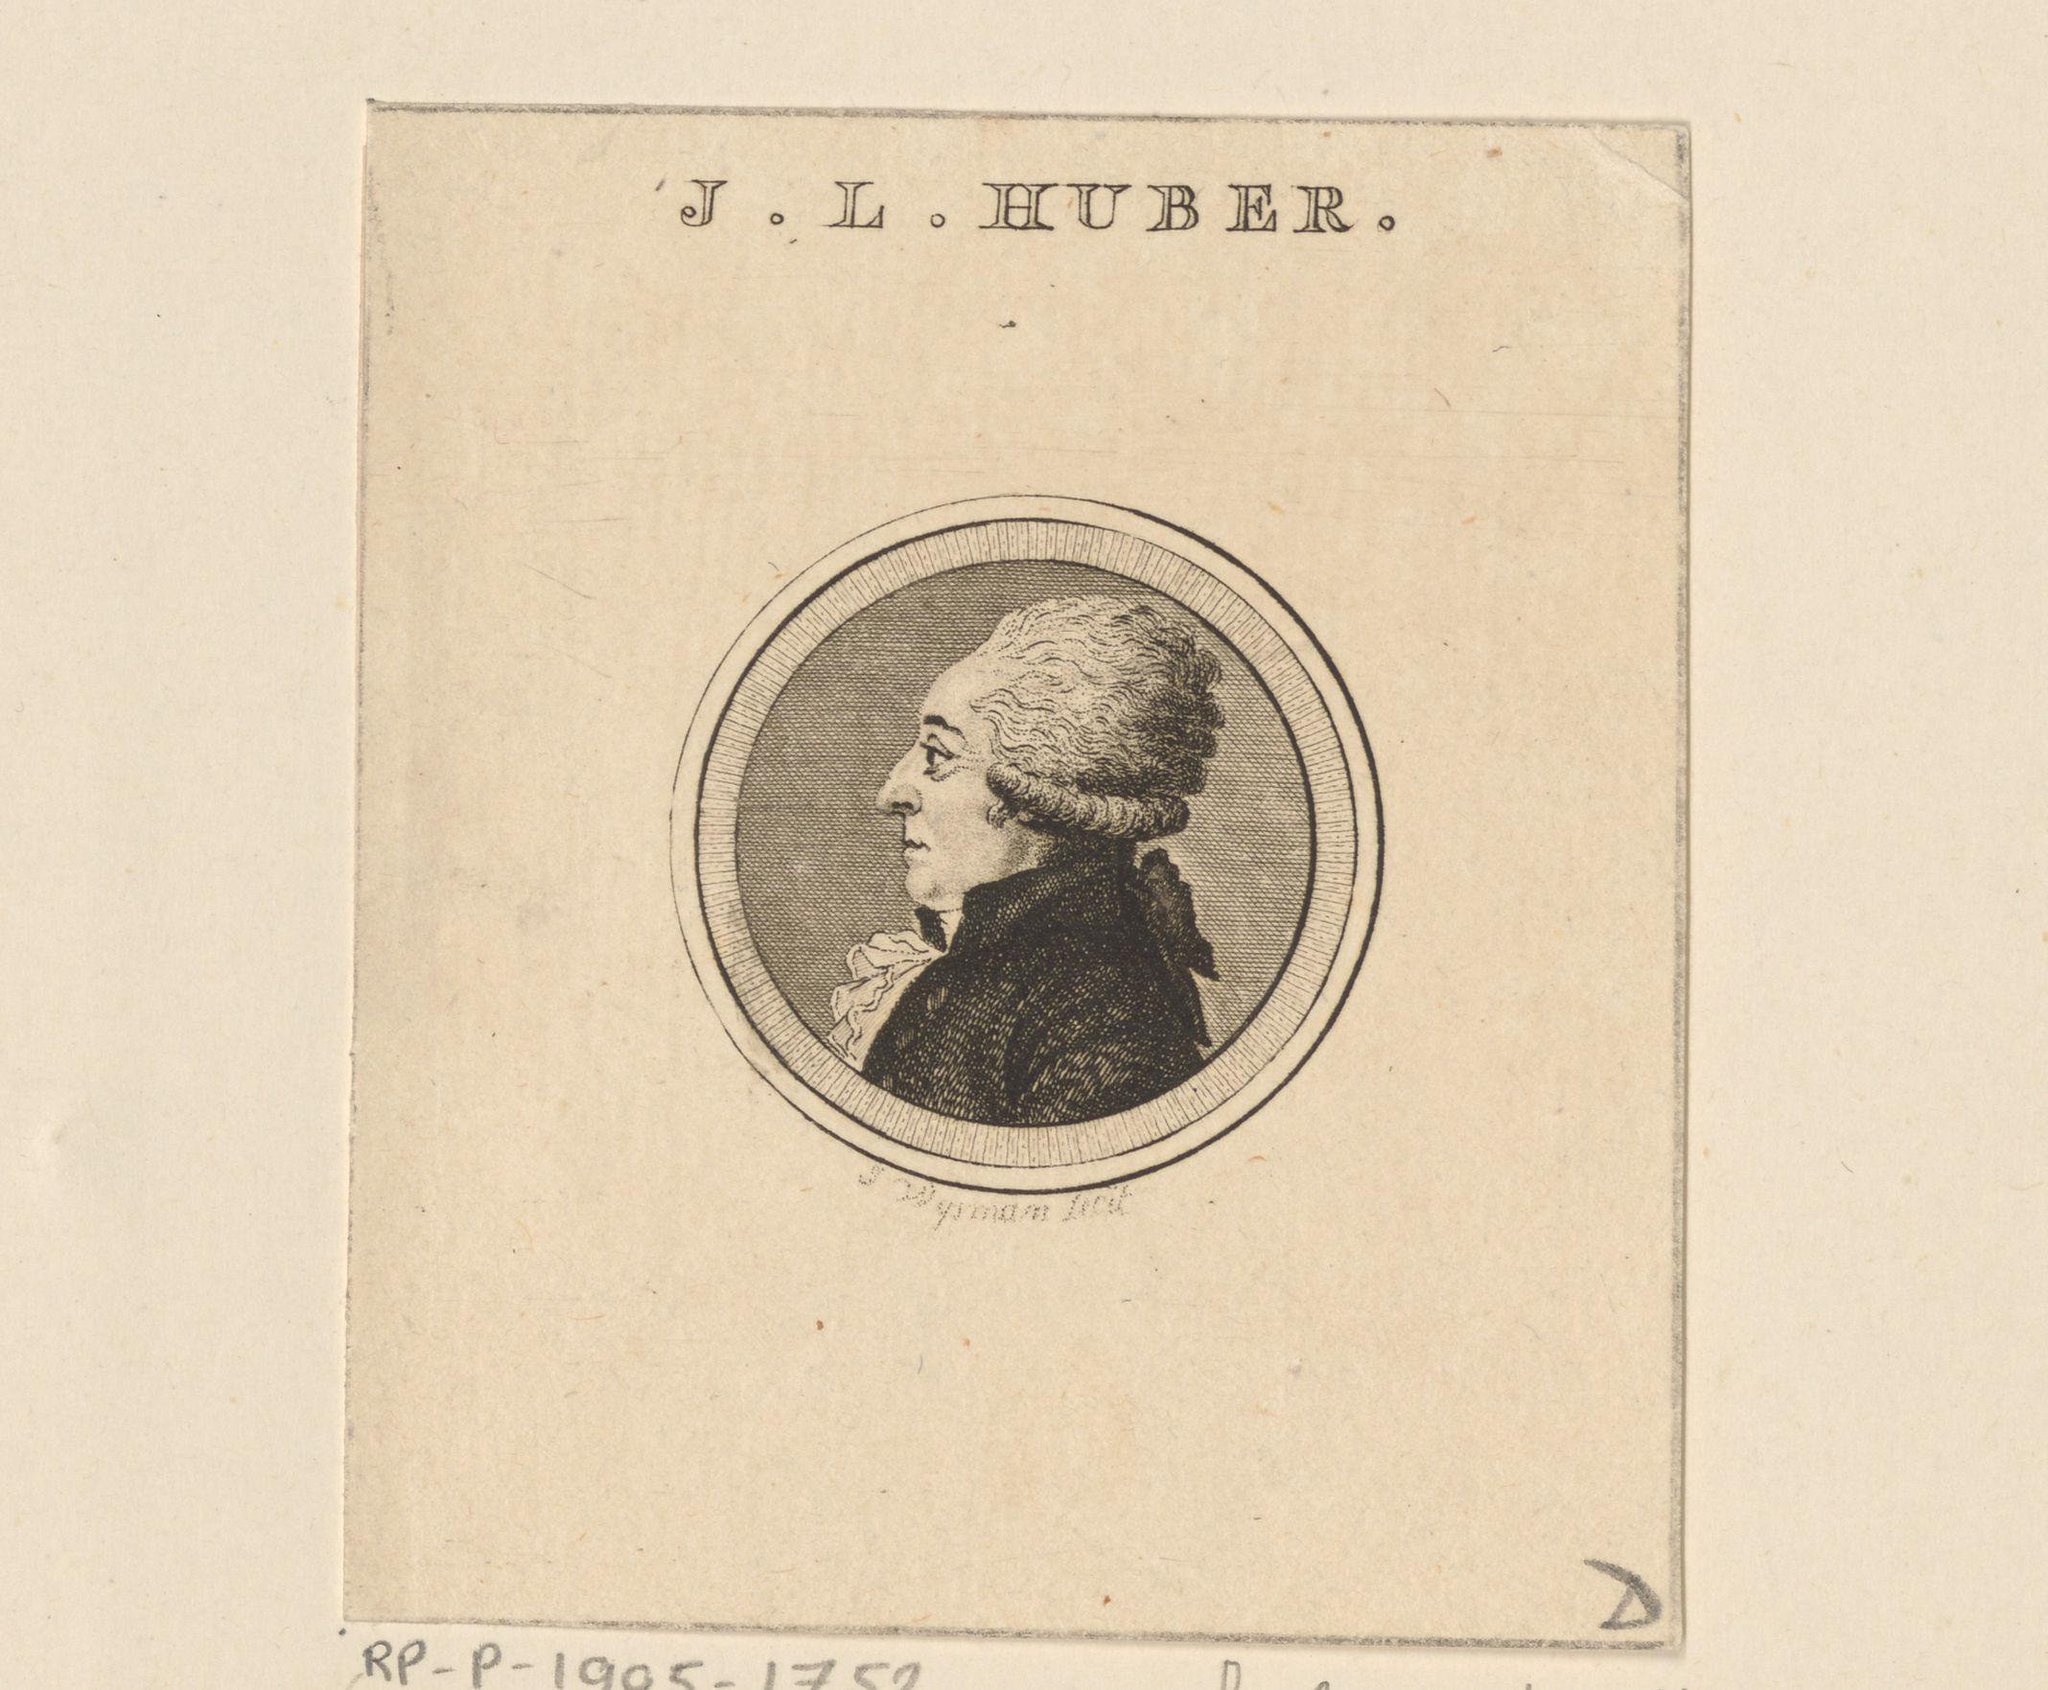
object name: print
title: Portret van Johannes Lambertus Huber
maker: jacobus wijsman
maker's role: print maker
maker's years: 1768-1827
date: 1796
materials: paper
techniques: etching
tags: mintmaster, historical persons, writer, poet, author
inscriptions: collector's mark: Lugt 2228